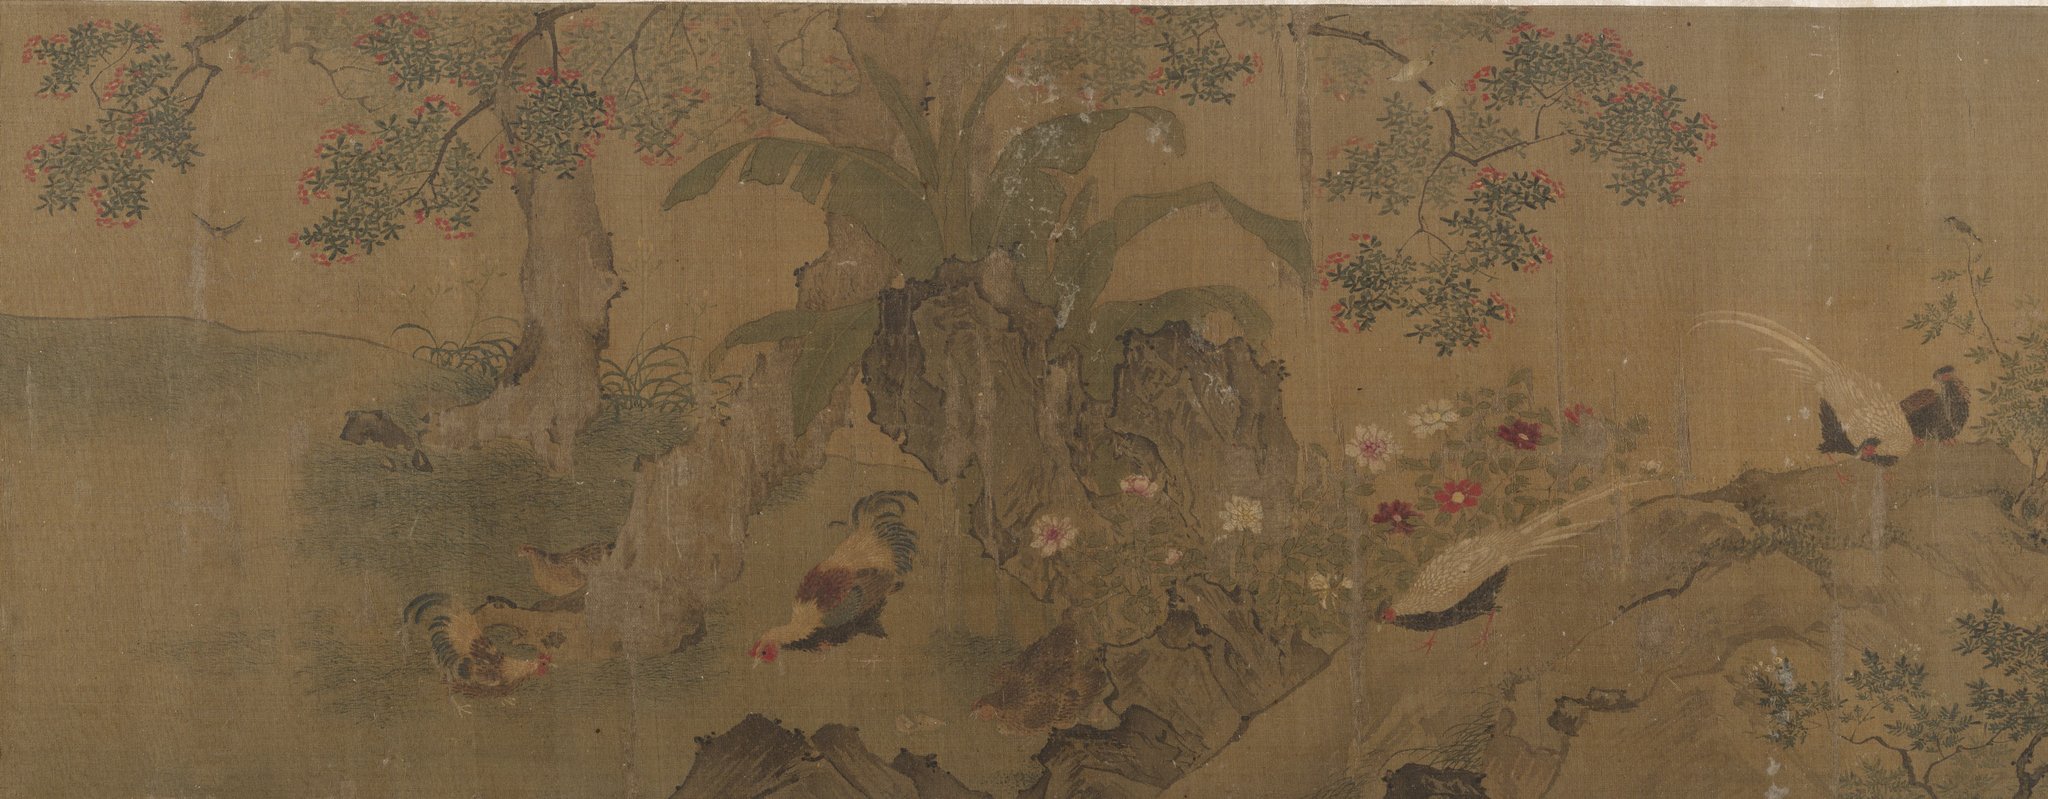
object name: handscroll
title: The Hundred Birds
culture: chinese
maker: dai wan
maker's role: artist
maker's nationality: chinese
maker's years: 1111-1125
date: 1368-1644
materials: ink, silk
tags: birds,roosters,flowers